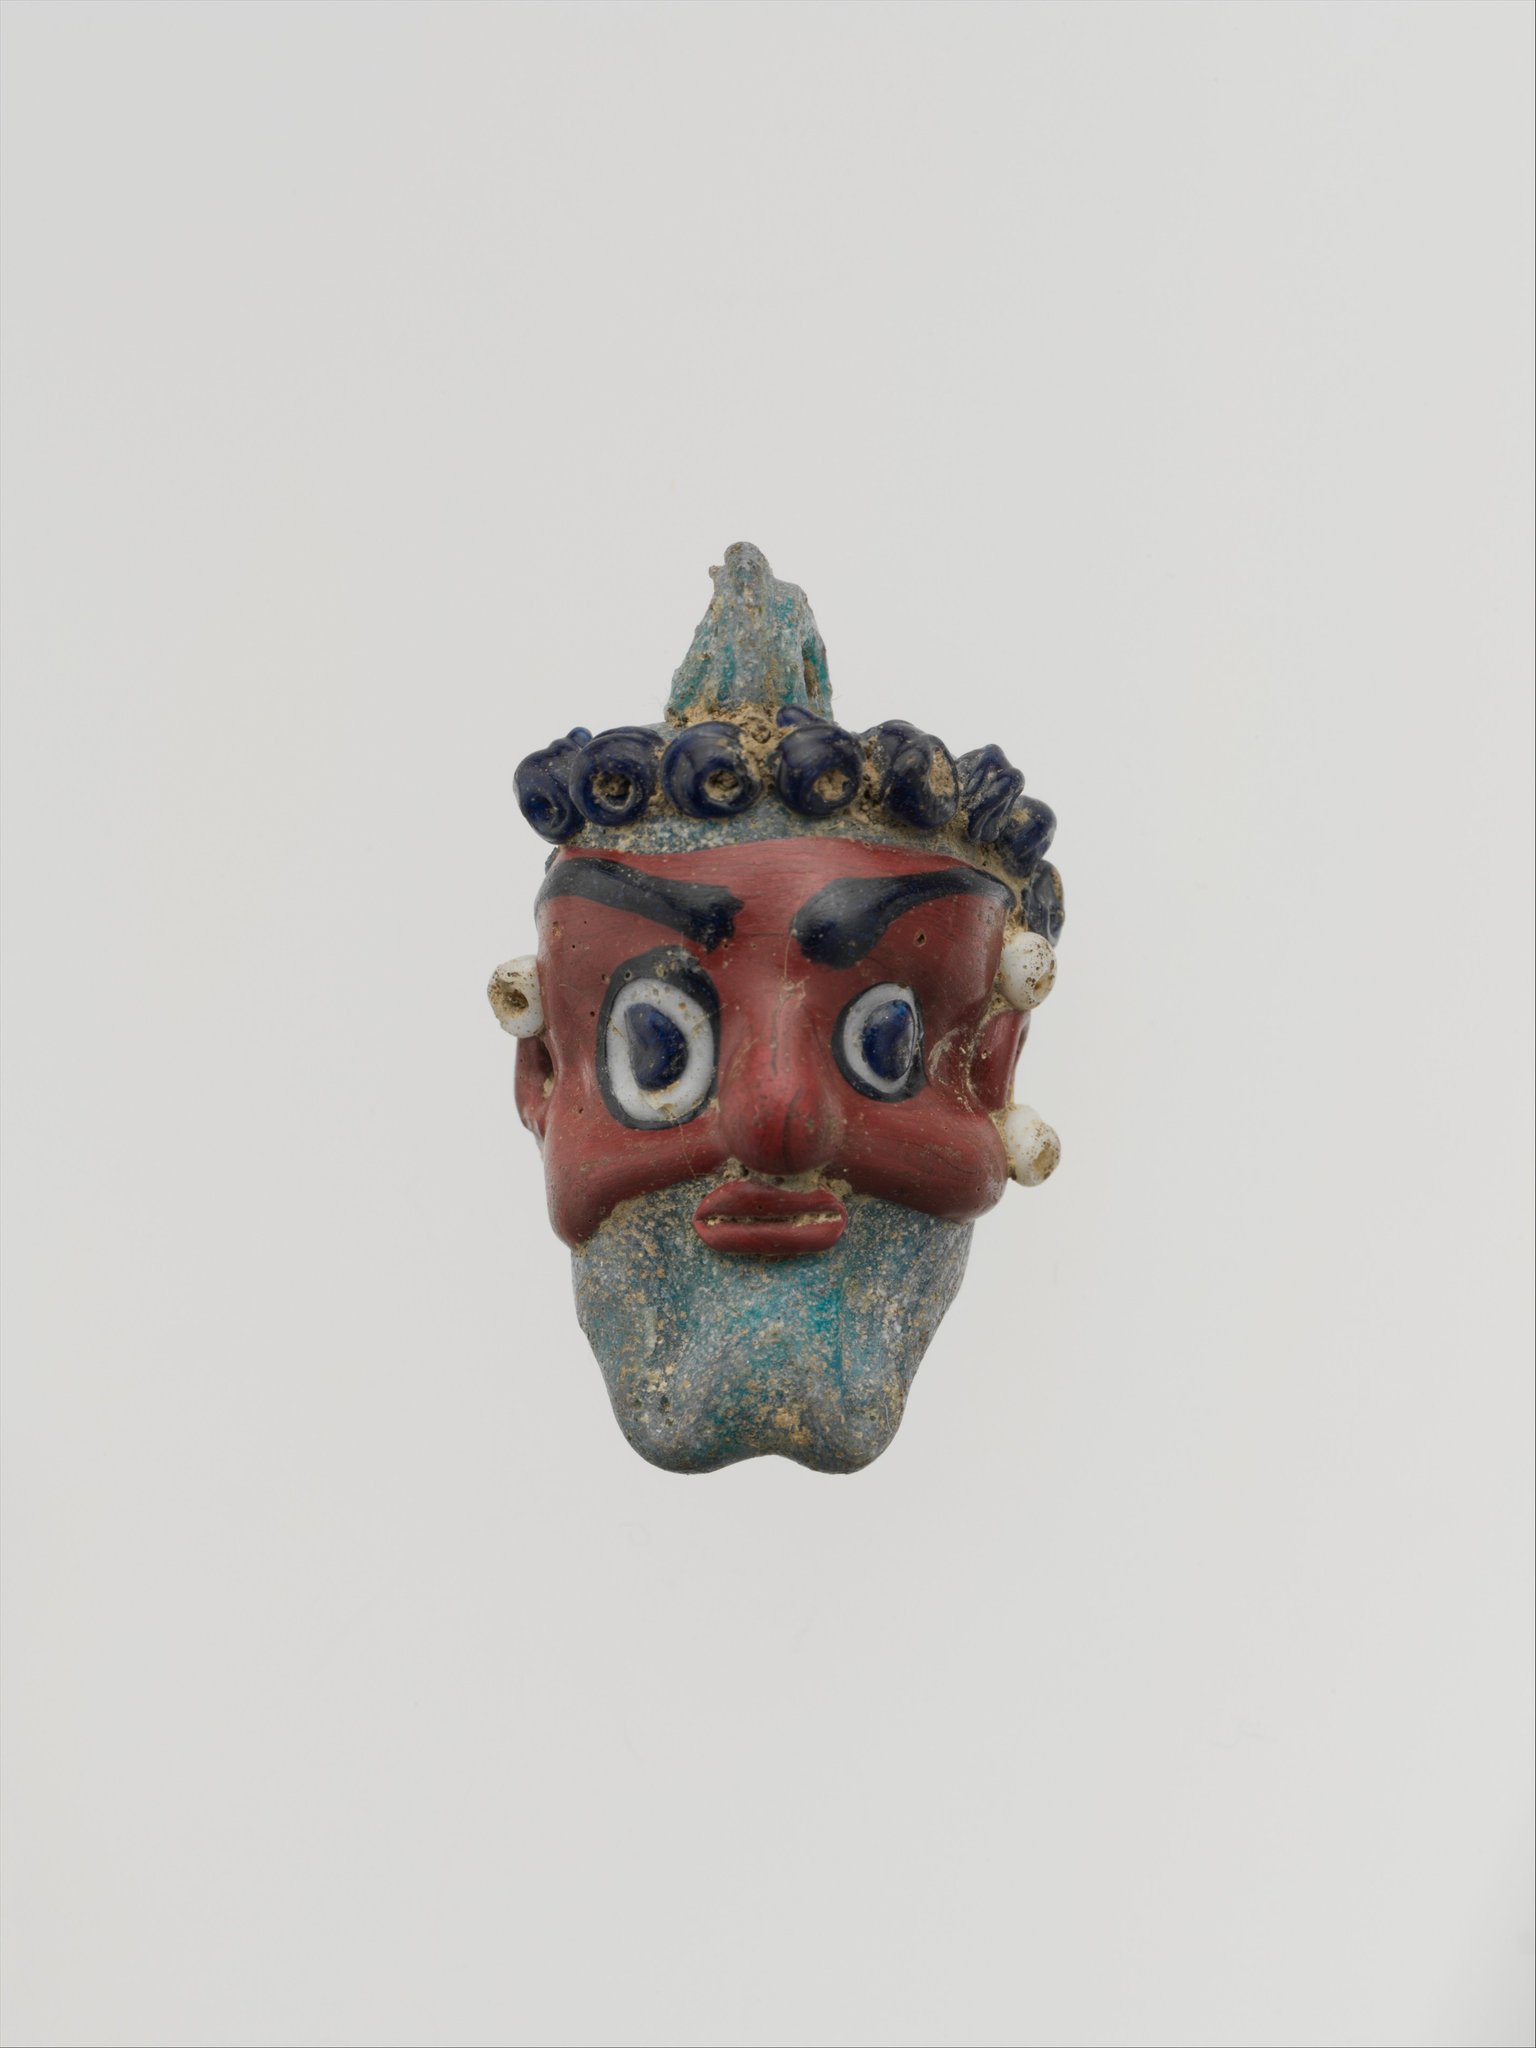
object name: head pendant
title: Glass head pendant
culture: carthaginian or phoenician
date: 500-401 BCE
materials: glass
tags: heads